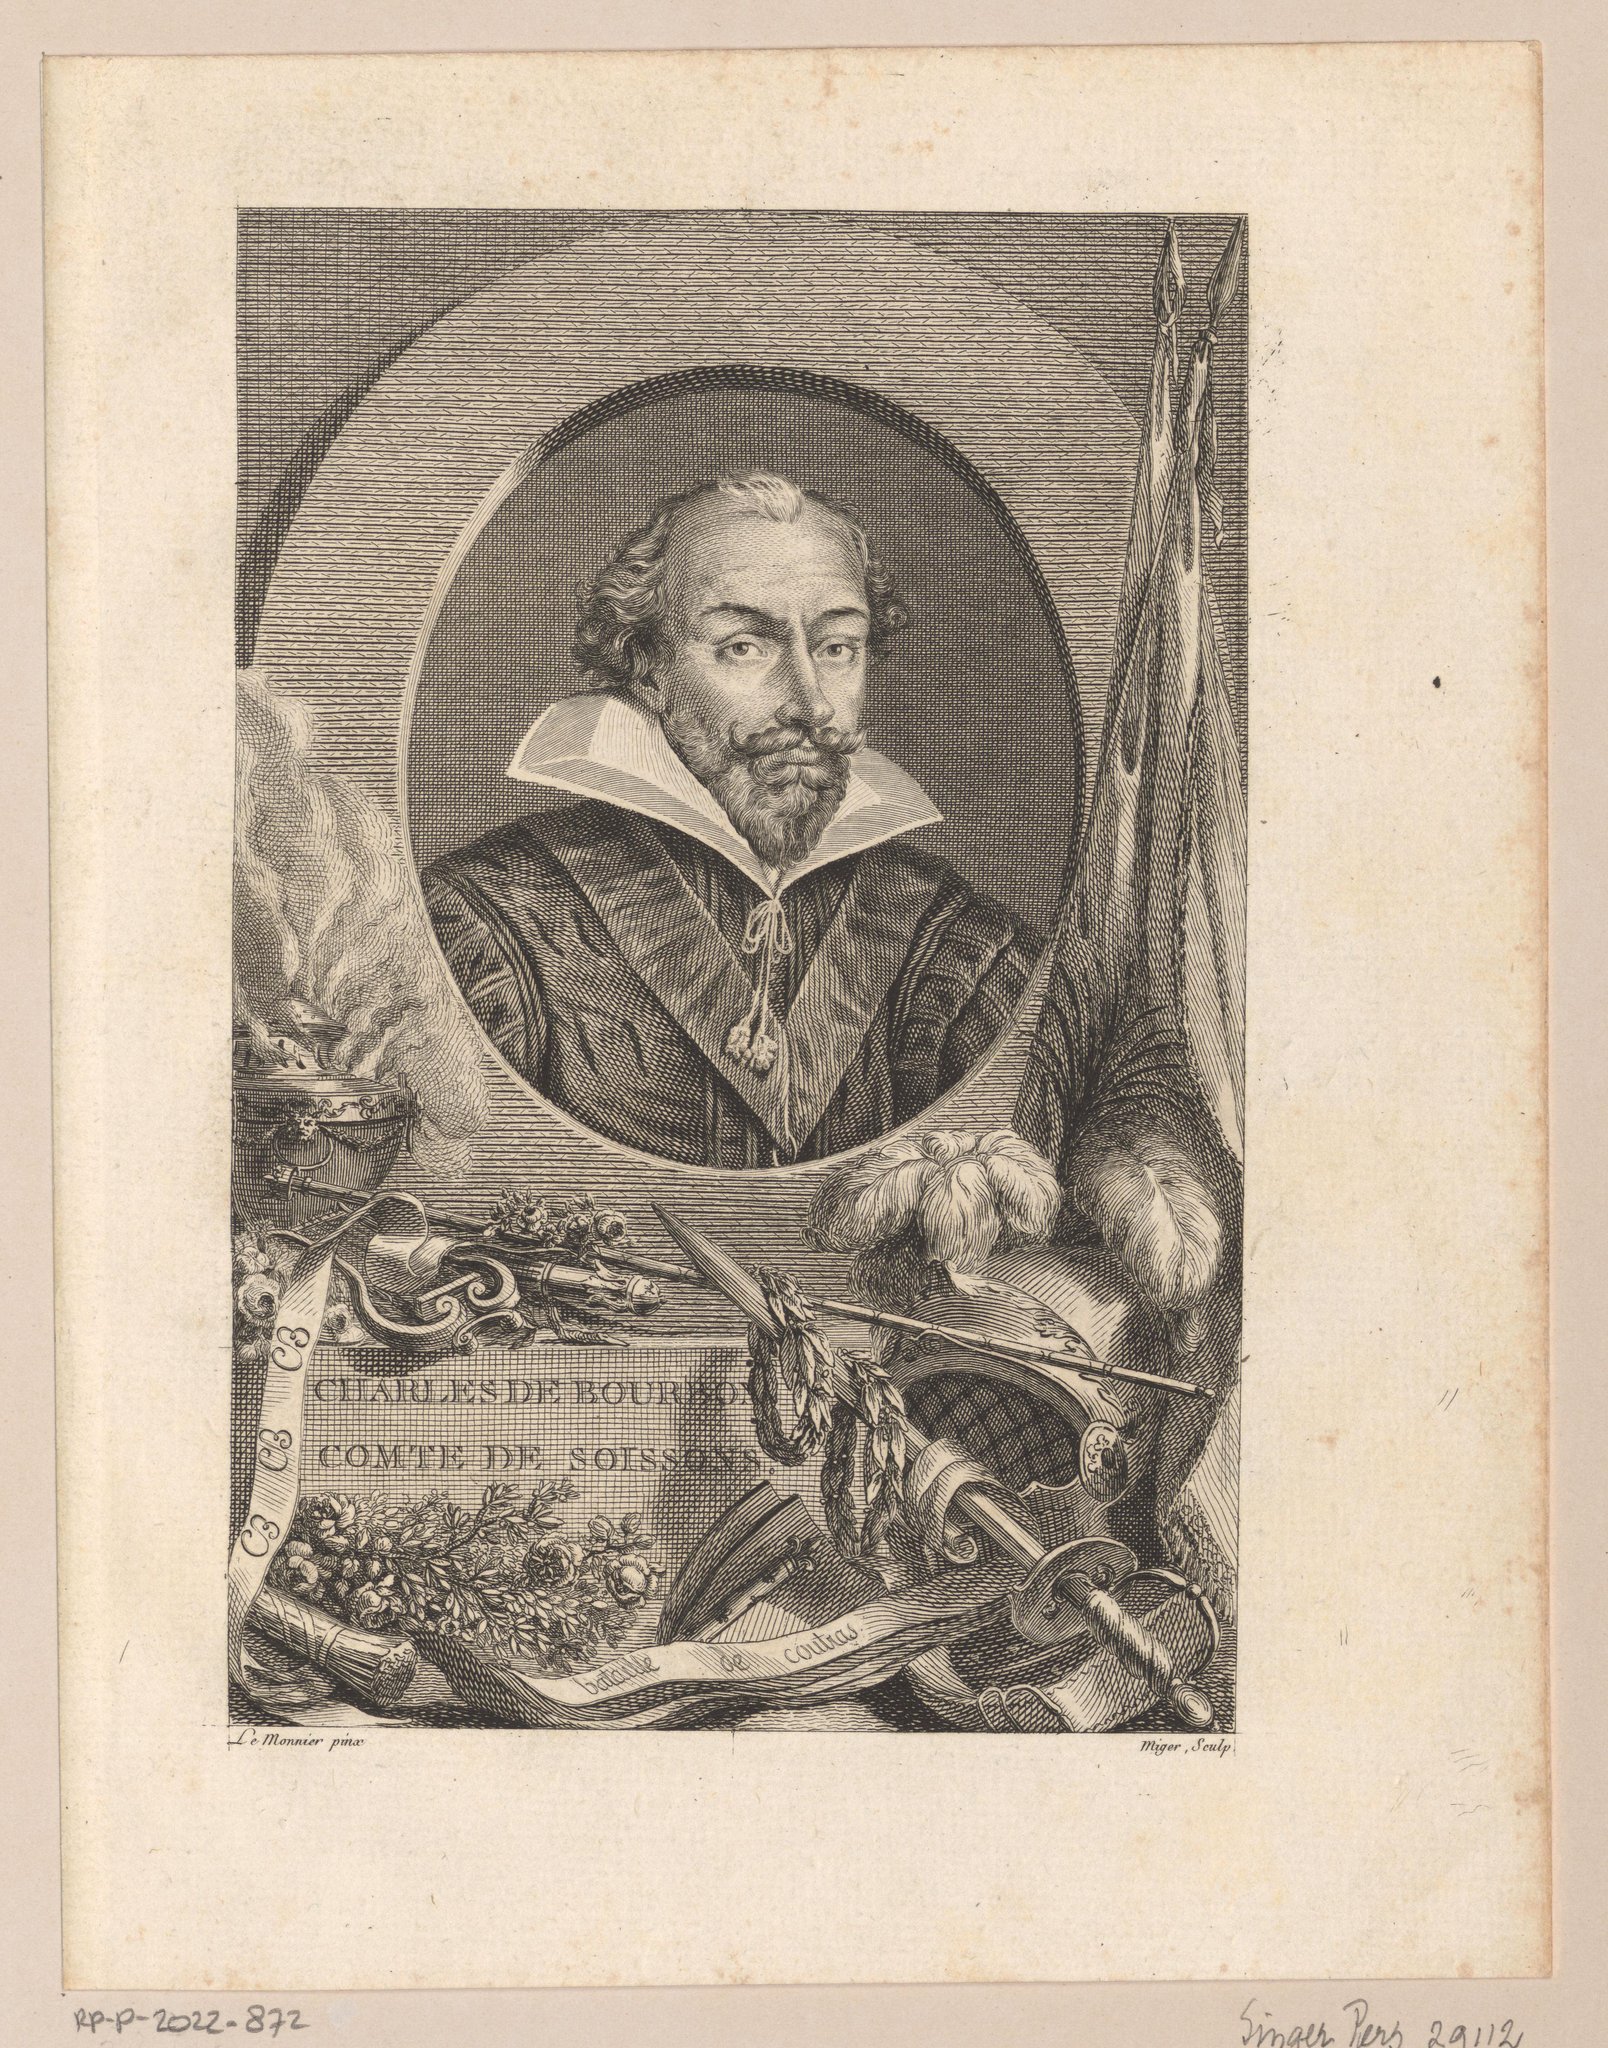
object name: print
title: Portret van Charles de Bourbon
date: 1788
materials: paper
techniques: engraving, etching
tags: historical persons, other sovereign (with title)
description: Prent waarschijnlijk uit: Désormeaux, Joseph-Louis-Ripault. Histoire de la maison de Bourbon. Parijs: L'Imprimerie Royale, dl. 5, 1788.